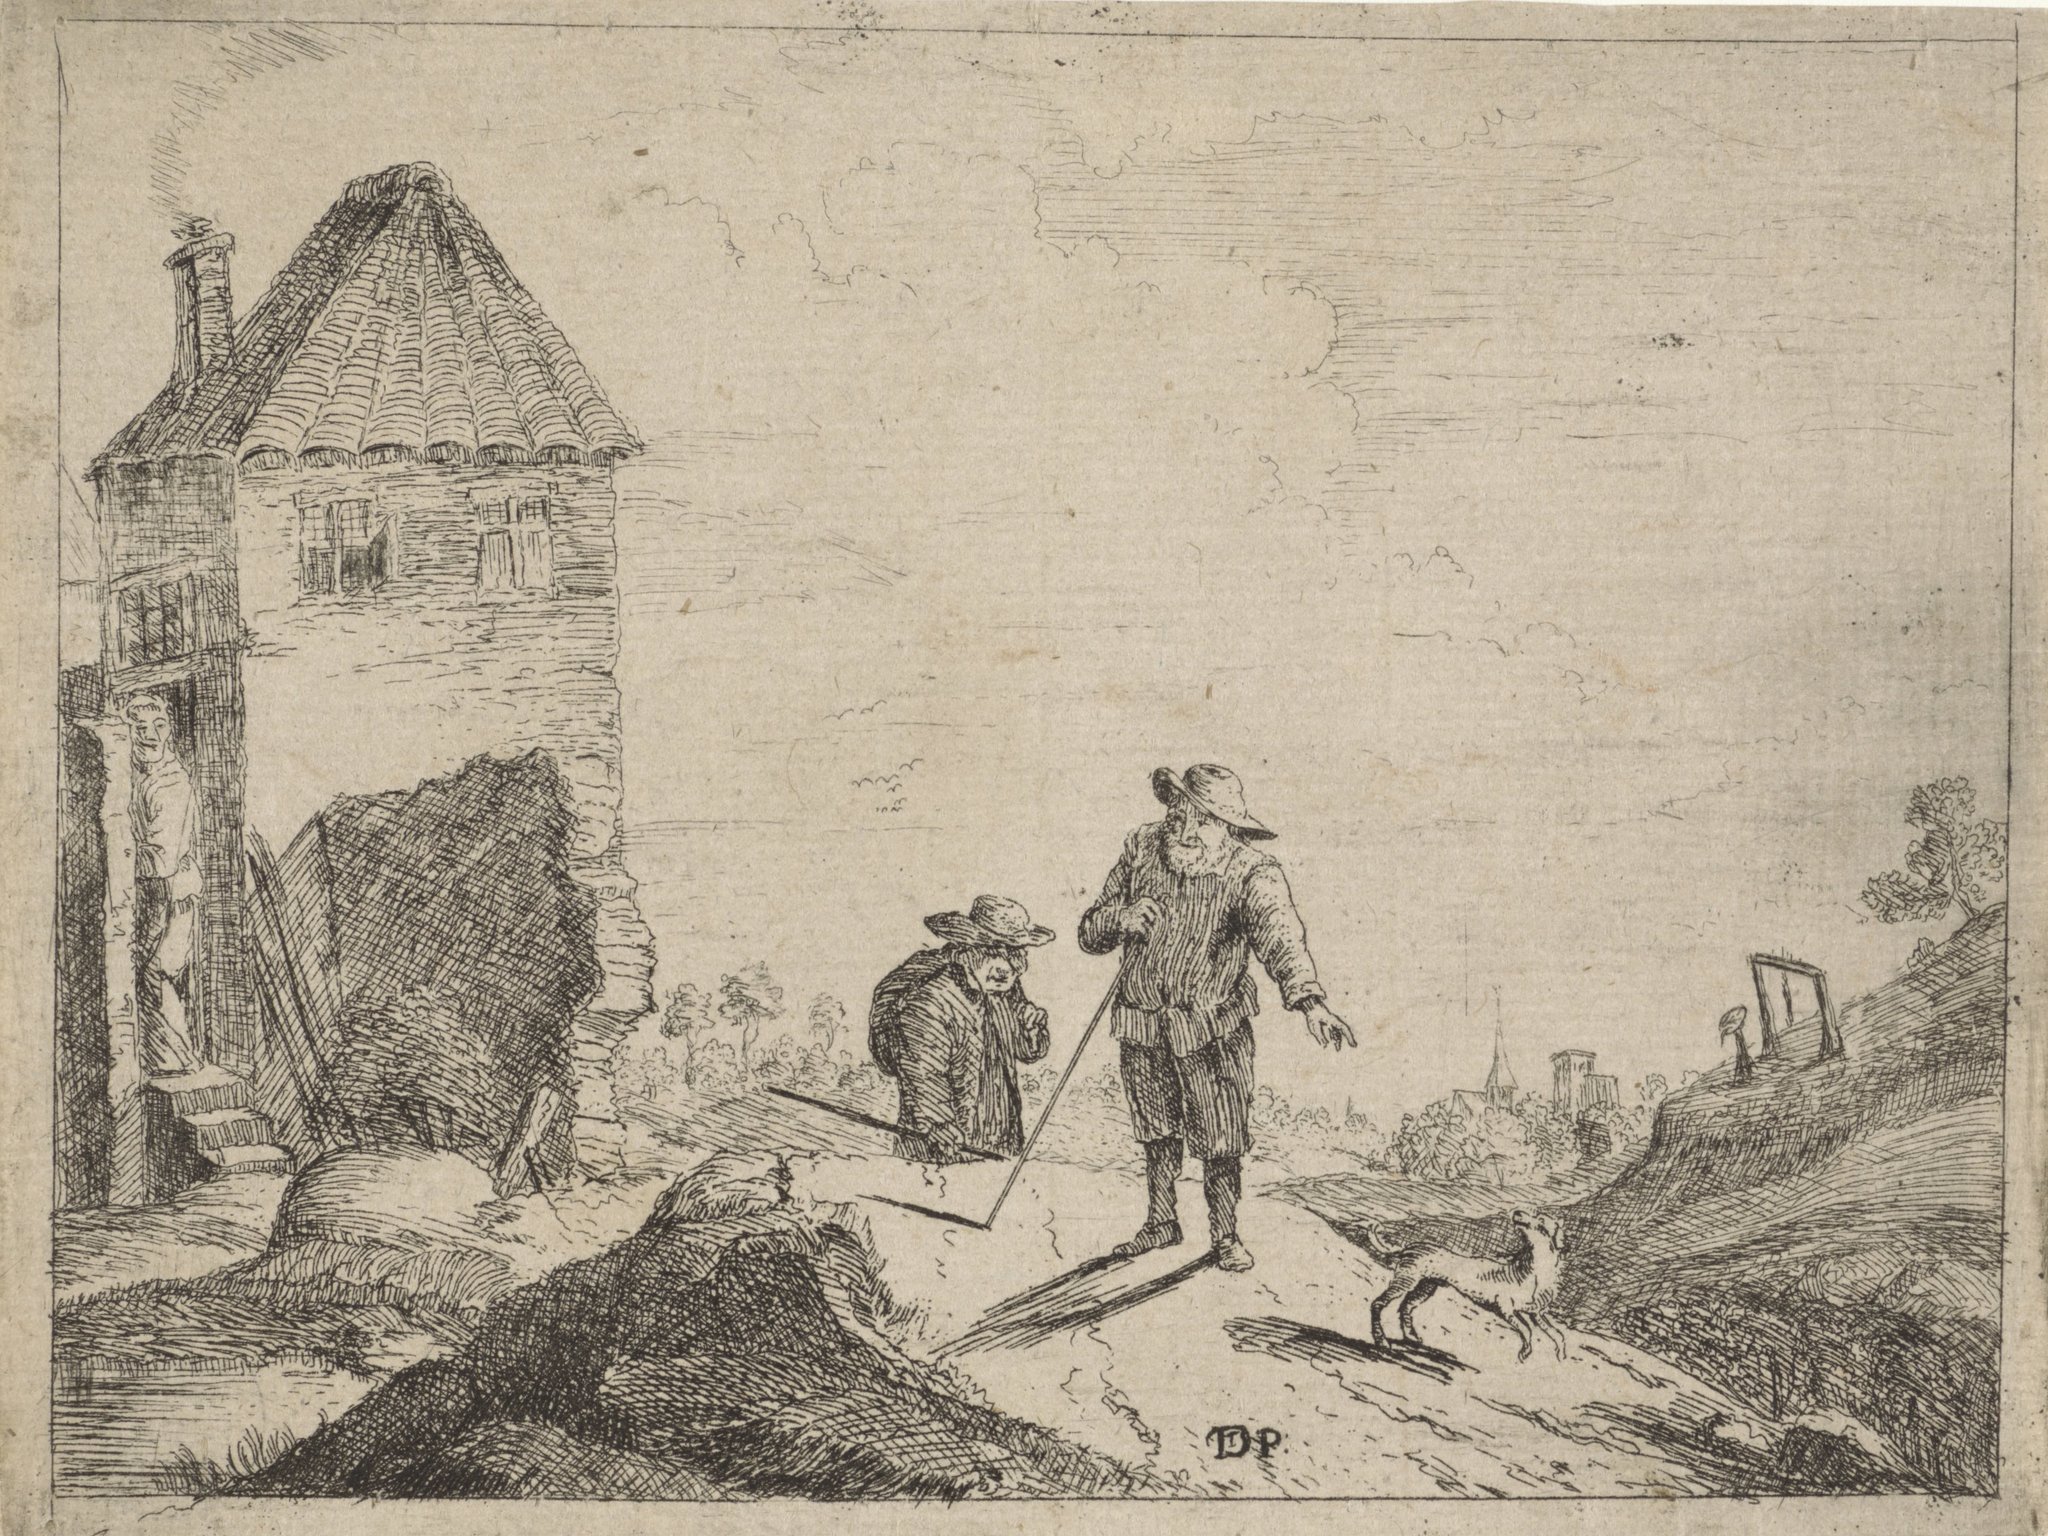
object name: print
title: Twee boeren met een hond op een landweg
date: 1704-1765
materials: paper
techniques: etching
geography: southern netherlands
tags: landscapes in the temperate zone, dog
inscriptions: collector's mark: Lugt 2228, collector's mark: Lugt 514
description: Landschap met twee boeren en een hond op een landweg. Links een woning met een man op een trapje. Rechts op een heuvel een man aan een galg.